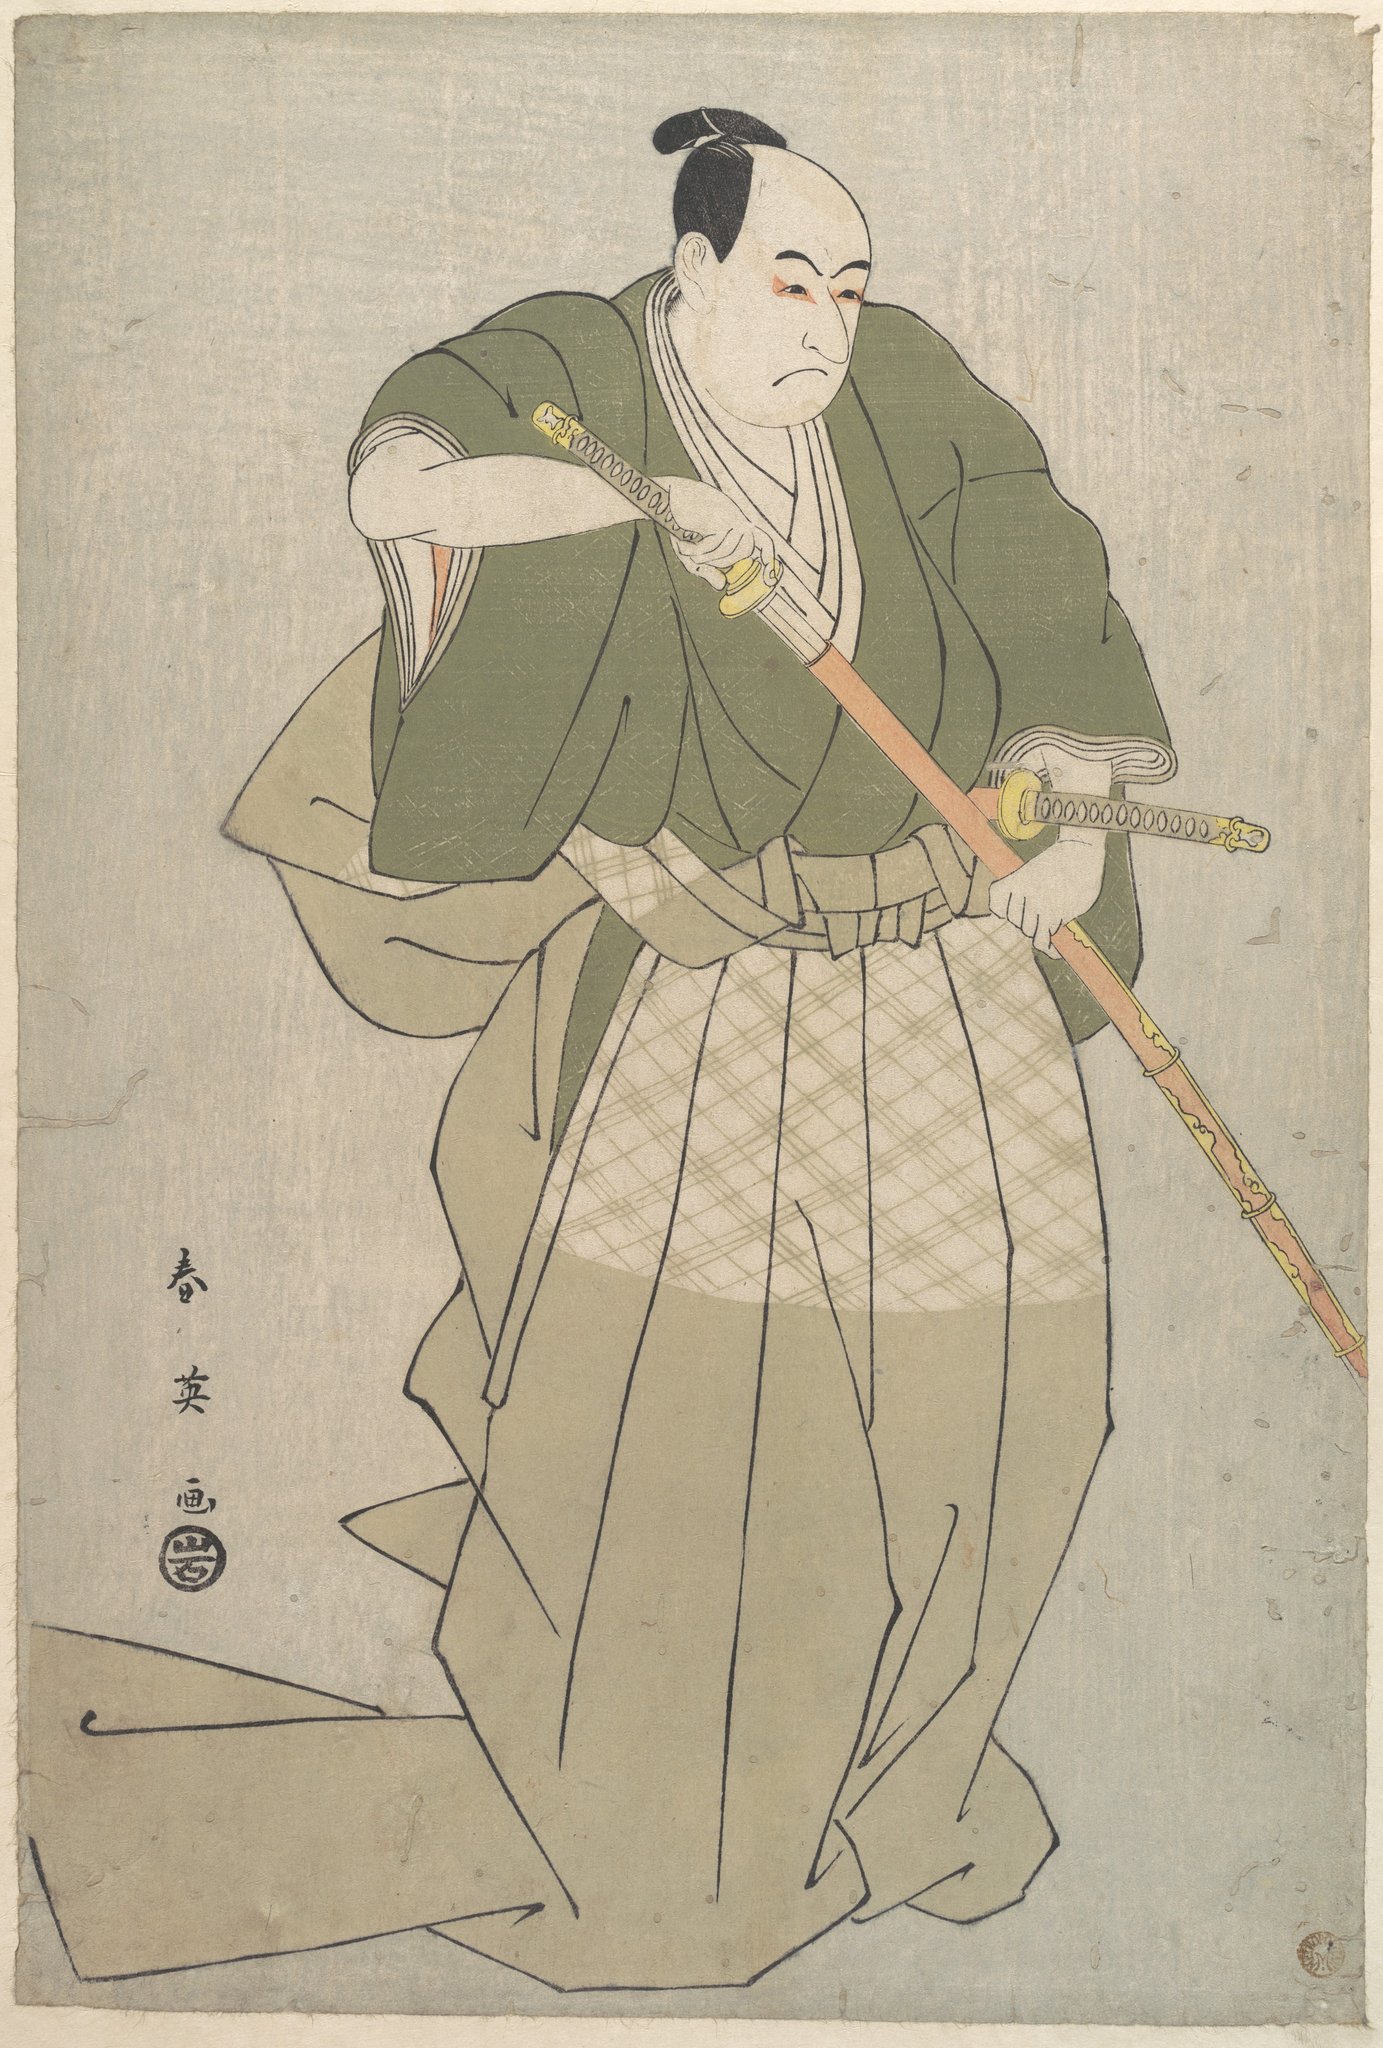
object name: woodblock print nishiki e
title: The Actor Ichikawa Omezō I as the Young Daimyo Momonoi Wakasanosuke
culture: japanese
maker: katsukawa shun'ei 勝川春英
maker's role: artist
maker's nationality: japanese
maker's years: 1762-1819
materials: ink, paper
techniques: nishiki e, woodblock print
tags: swords,men,actors